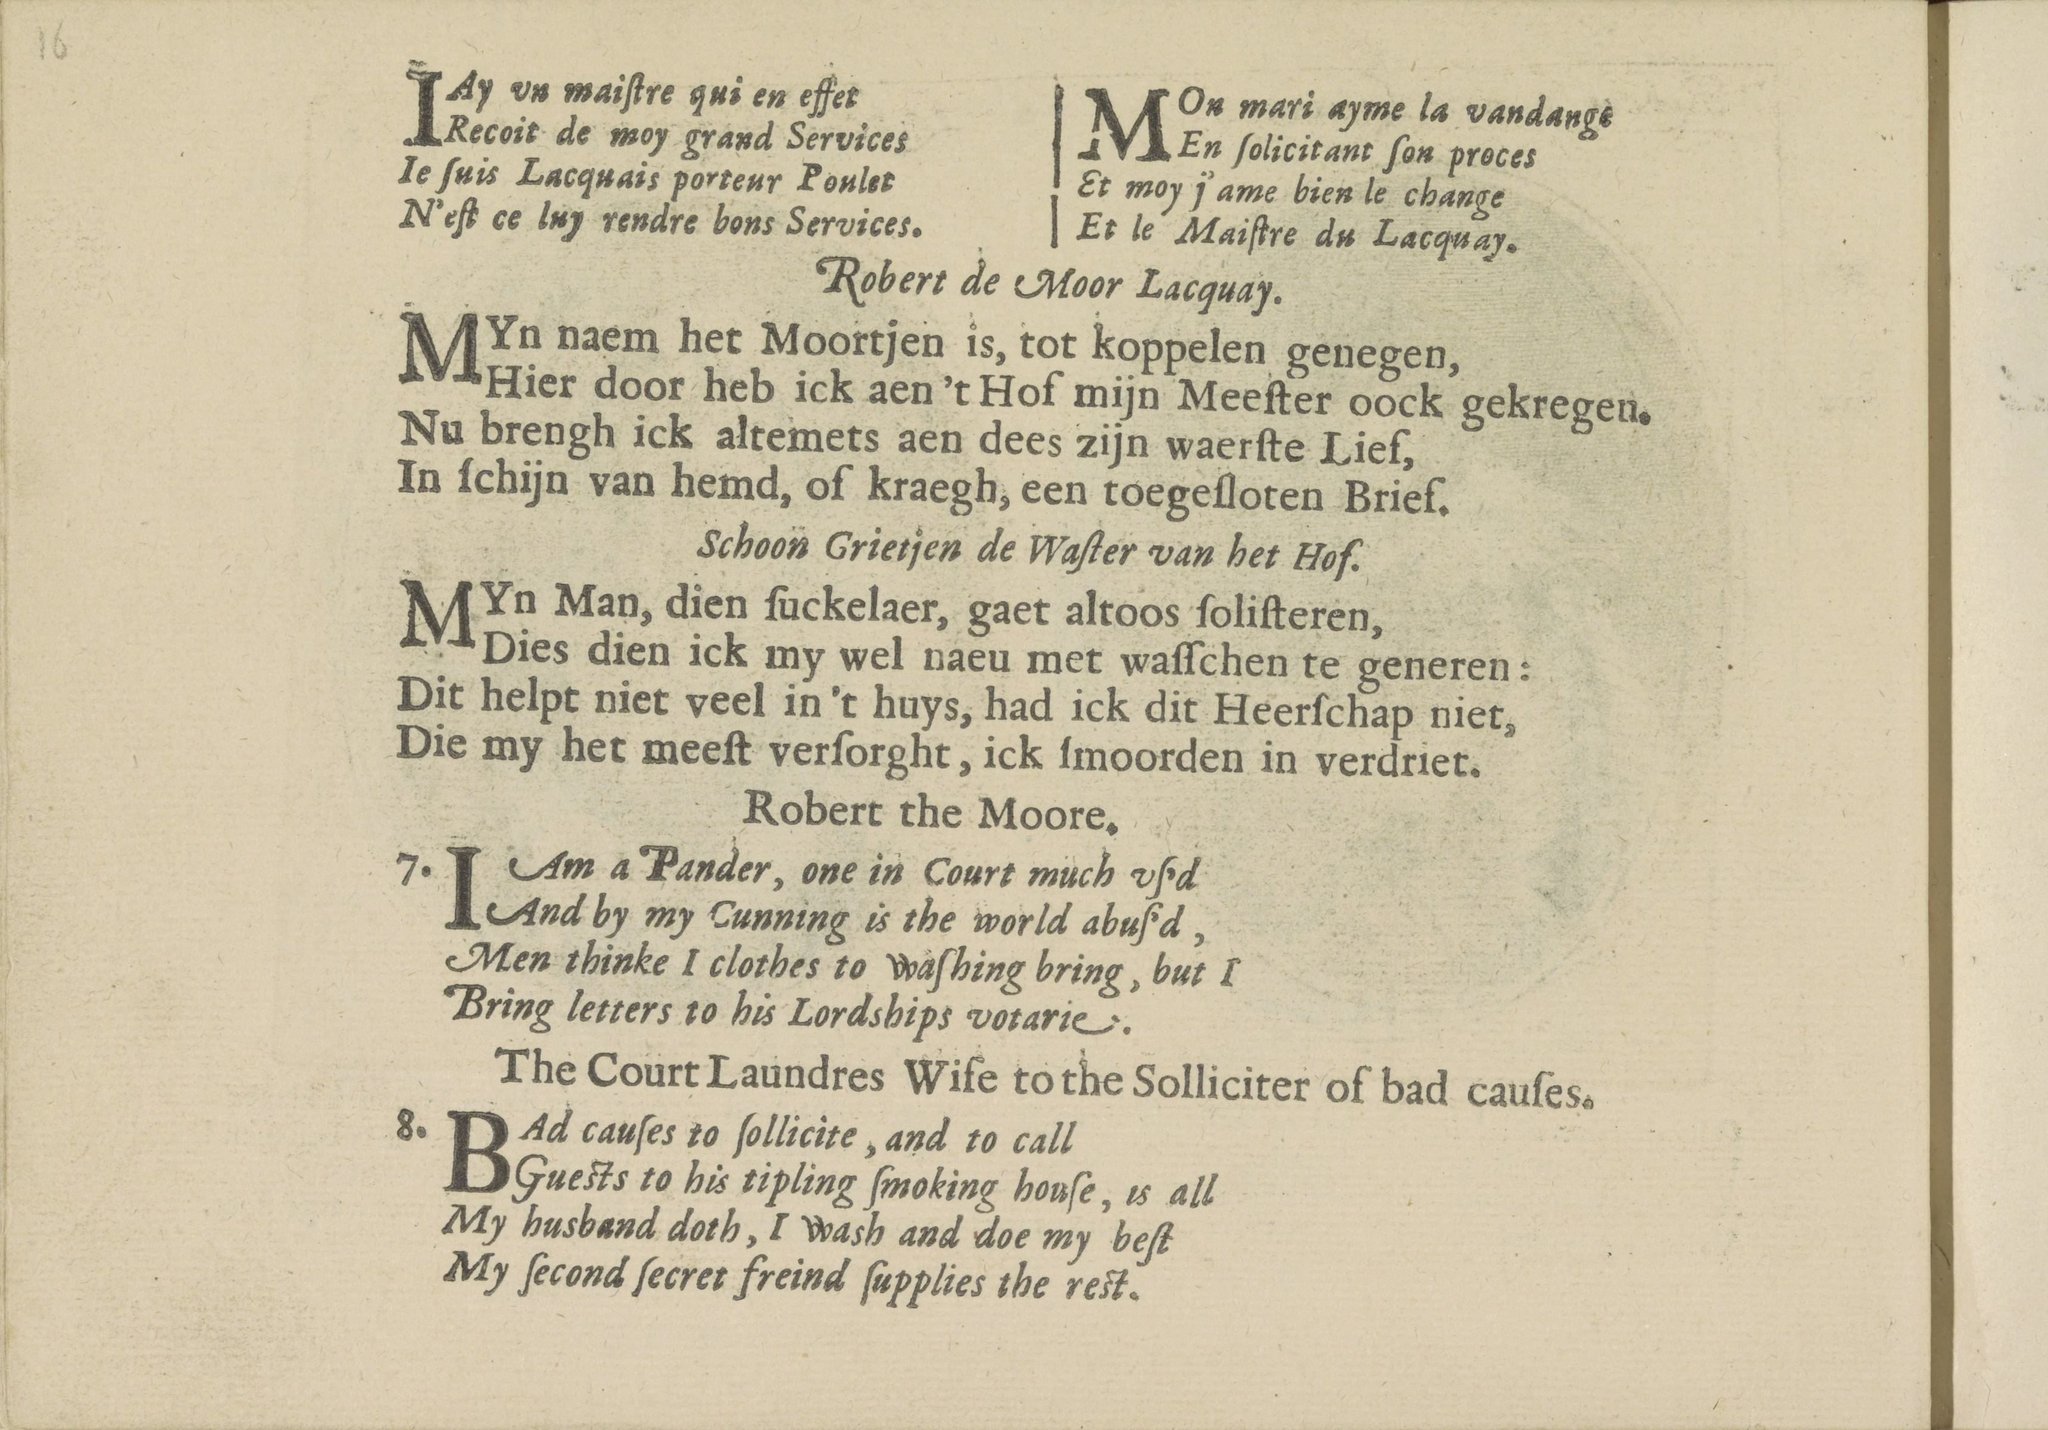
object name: album leaf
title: Kwatrijnen bij voorstellingen van een lakei en een wasvrouw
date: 1641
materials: paper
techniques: letterpress printing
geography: amsterdam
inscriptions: date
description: Drie keer twee kwatrijnen in het Frans, Nederlands en Engels bij voorstellingen van een lakei en een wasvrouw. Het blad maakt deel uit van een album.